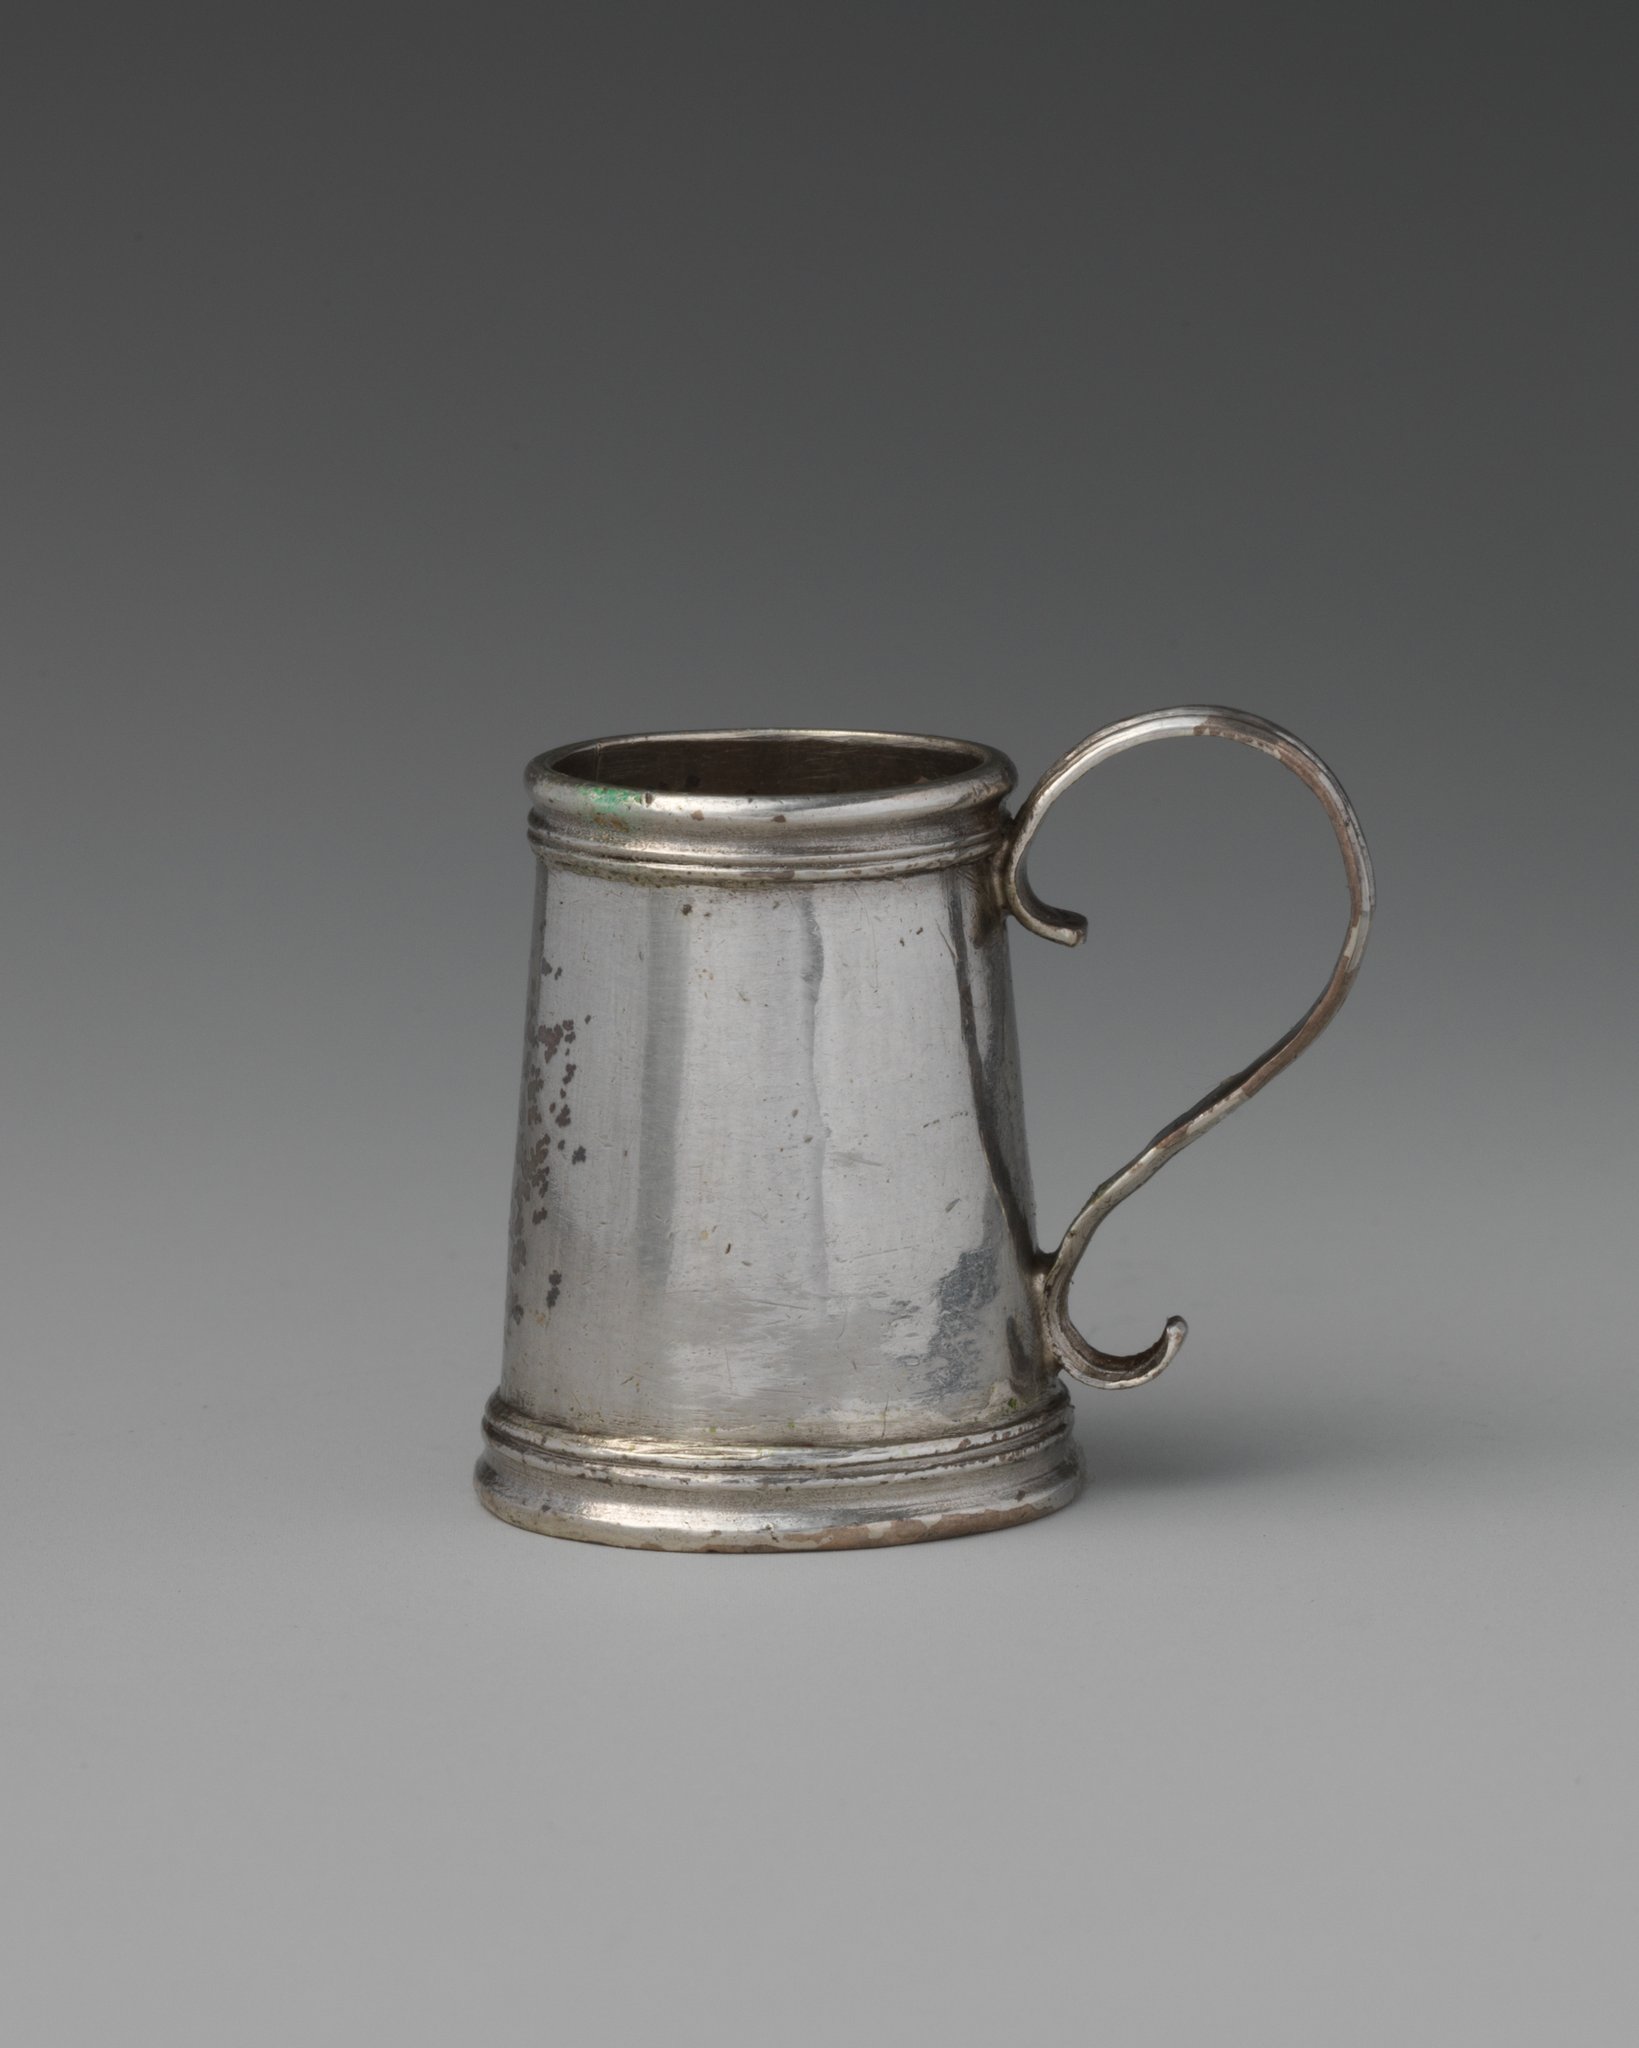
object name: mug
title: Miniature mug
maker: david clayton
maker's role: maker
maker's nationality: british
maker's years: 1659-1719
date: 1667-1733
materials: silver